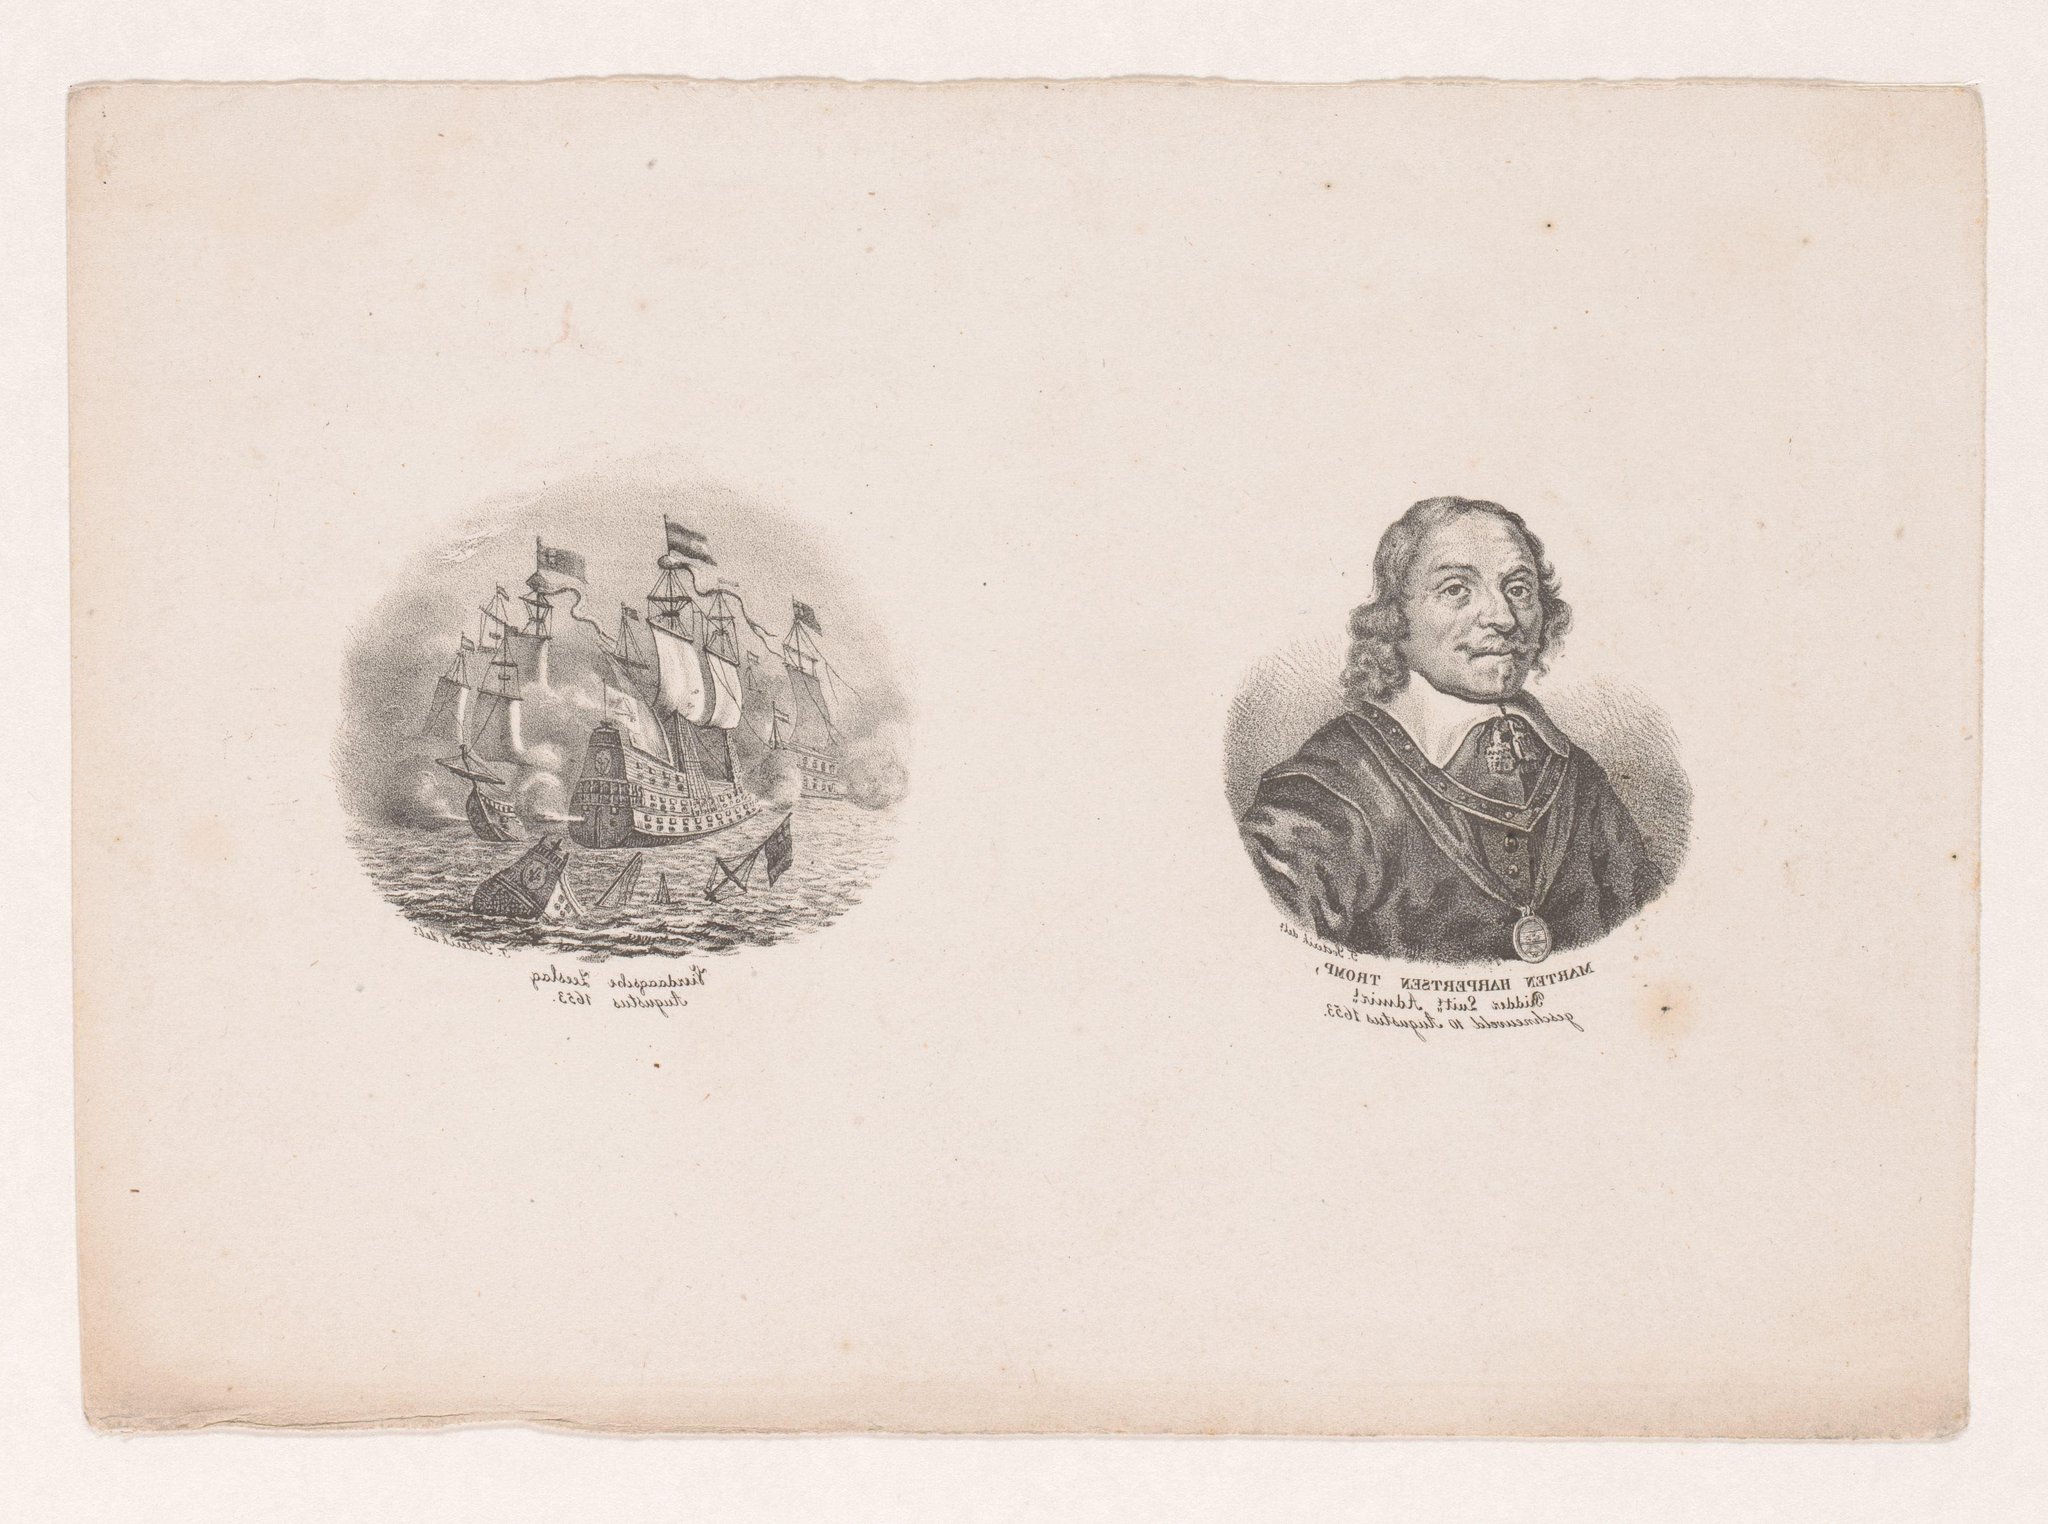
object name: print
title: Vierdaagsche Zeeslag Augustus 1653 / Marten Harpertsen Tromp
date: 1820-1883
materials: paper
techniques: lithograph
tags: maarten harpertszoon tromp, battle (+ naval force), commander-in-chief, admiral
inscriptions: collector's mark: Lugt 2228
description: Twee voorstellingen op een blad. Links de slag bij Terheide. Rechts het portret van admiraal Tromp.